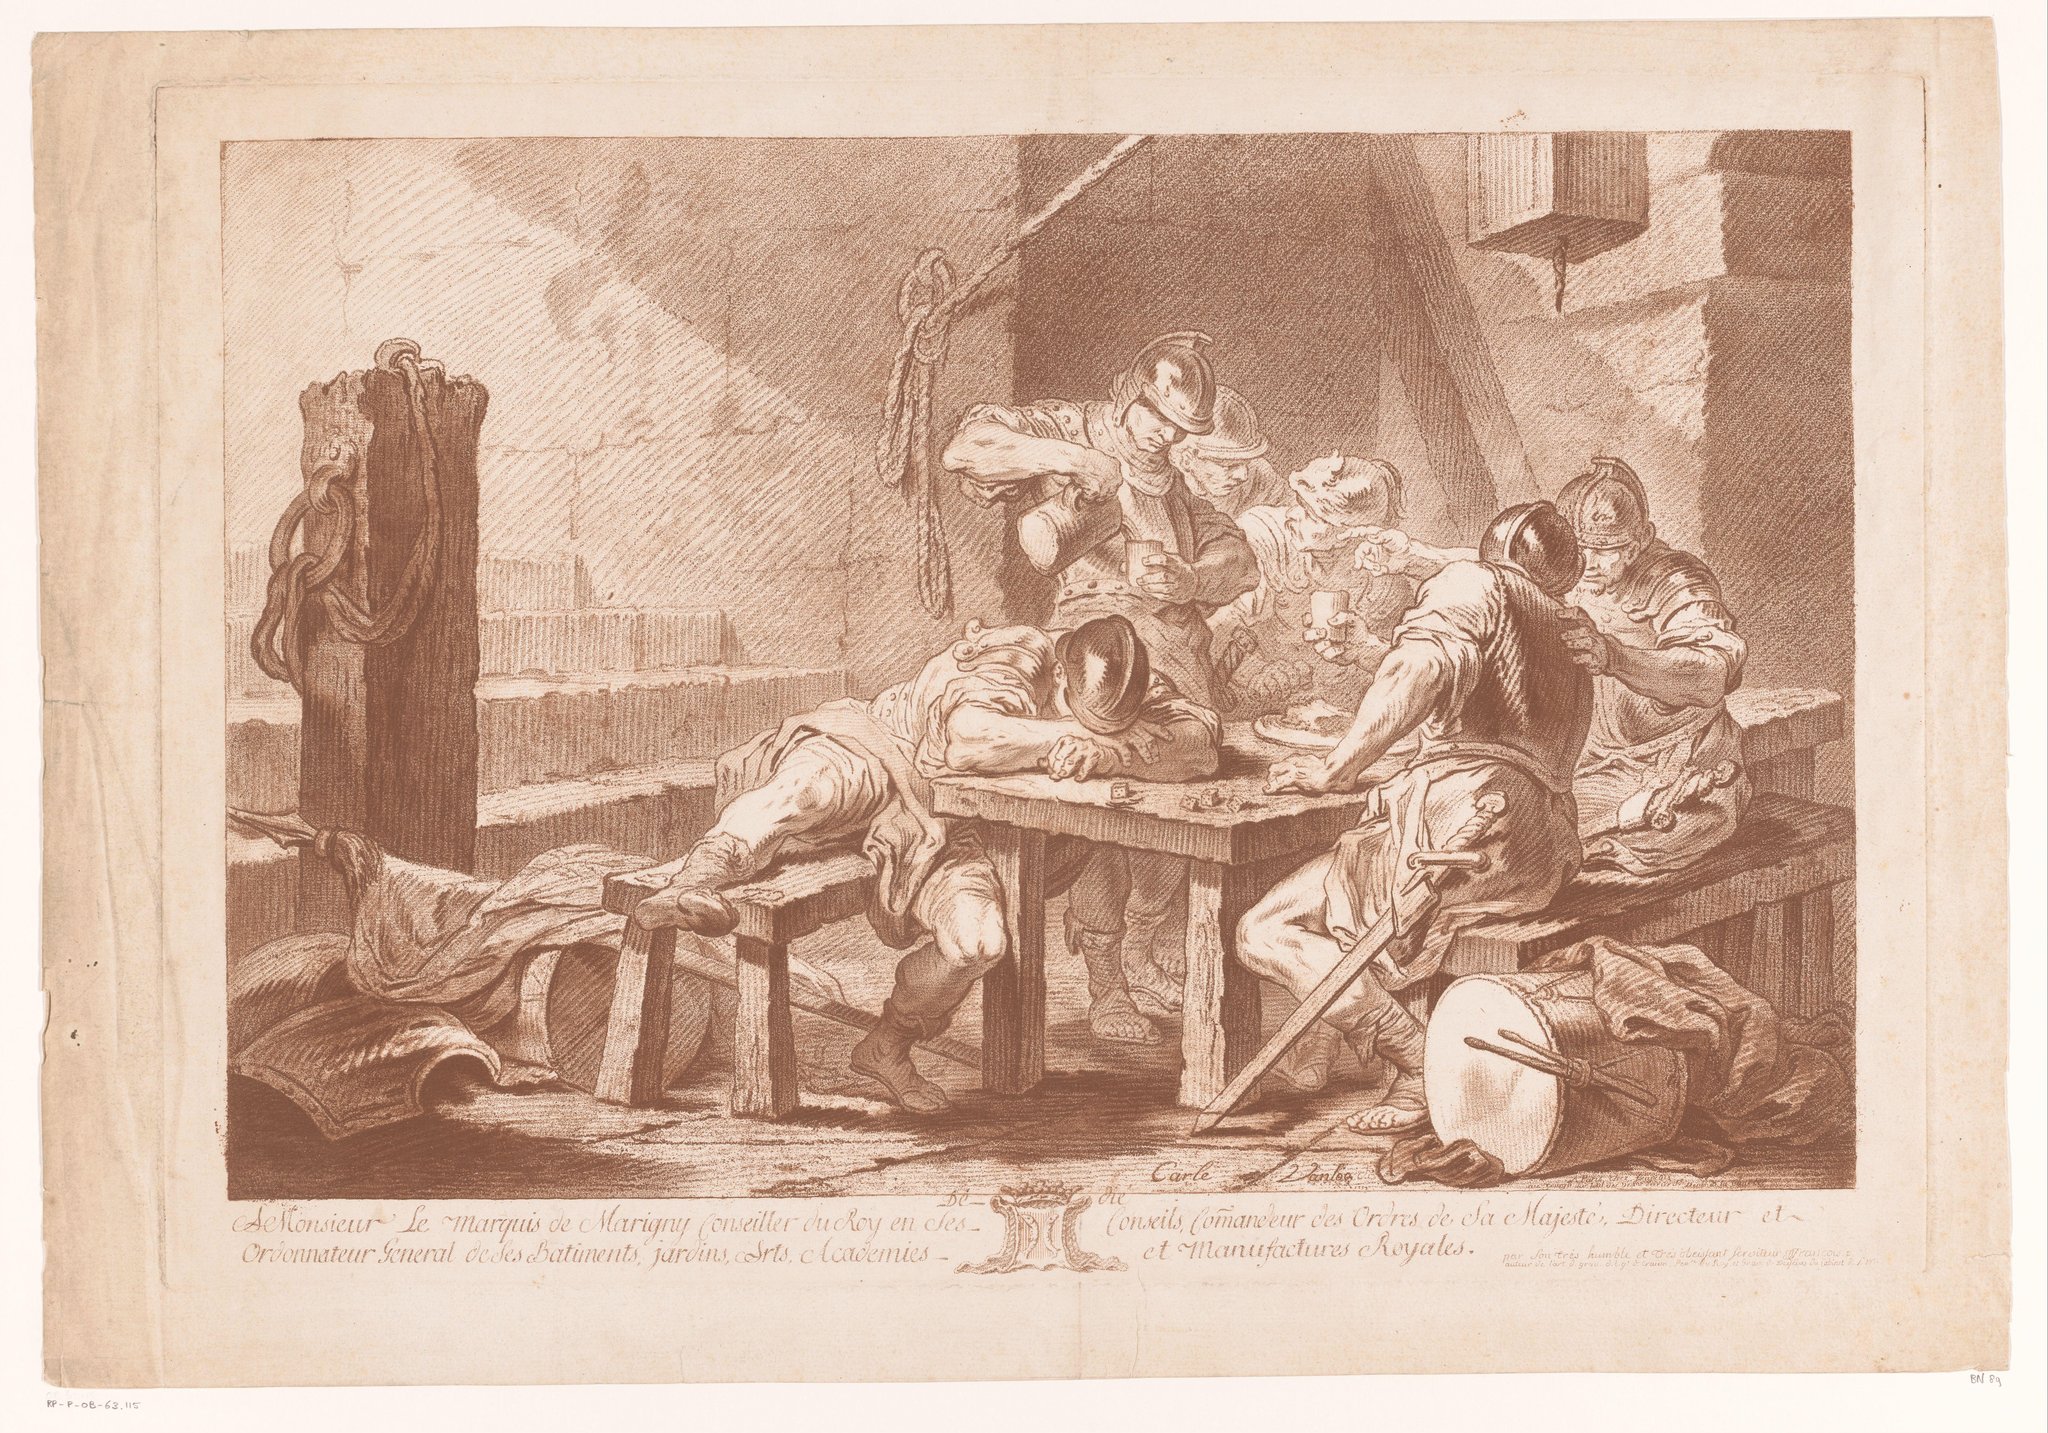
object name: print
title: Drinkende en dobbelende soldaten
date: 1758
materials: paper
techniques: printmaking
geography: france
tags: dice, recreation ~ the soldier off duty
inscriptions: watermark